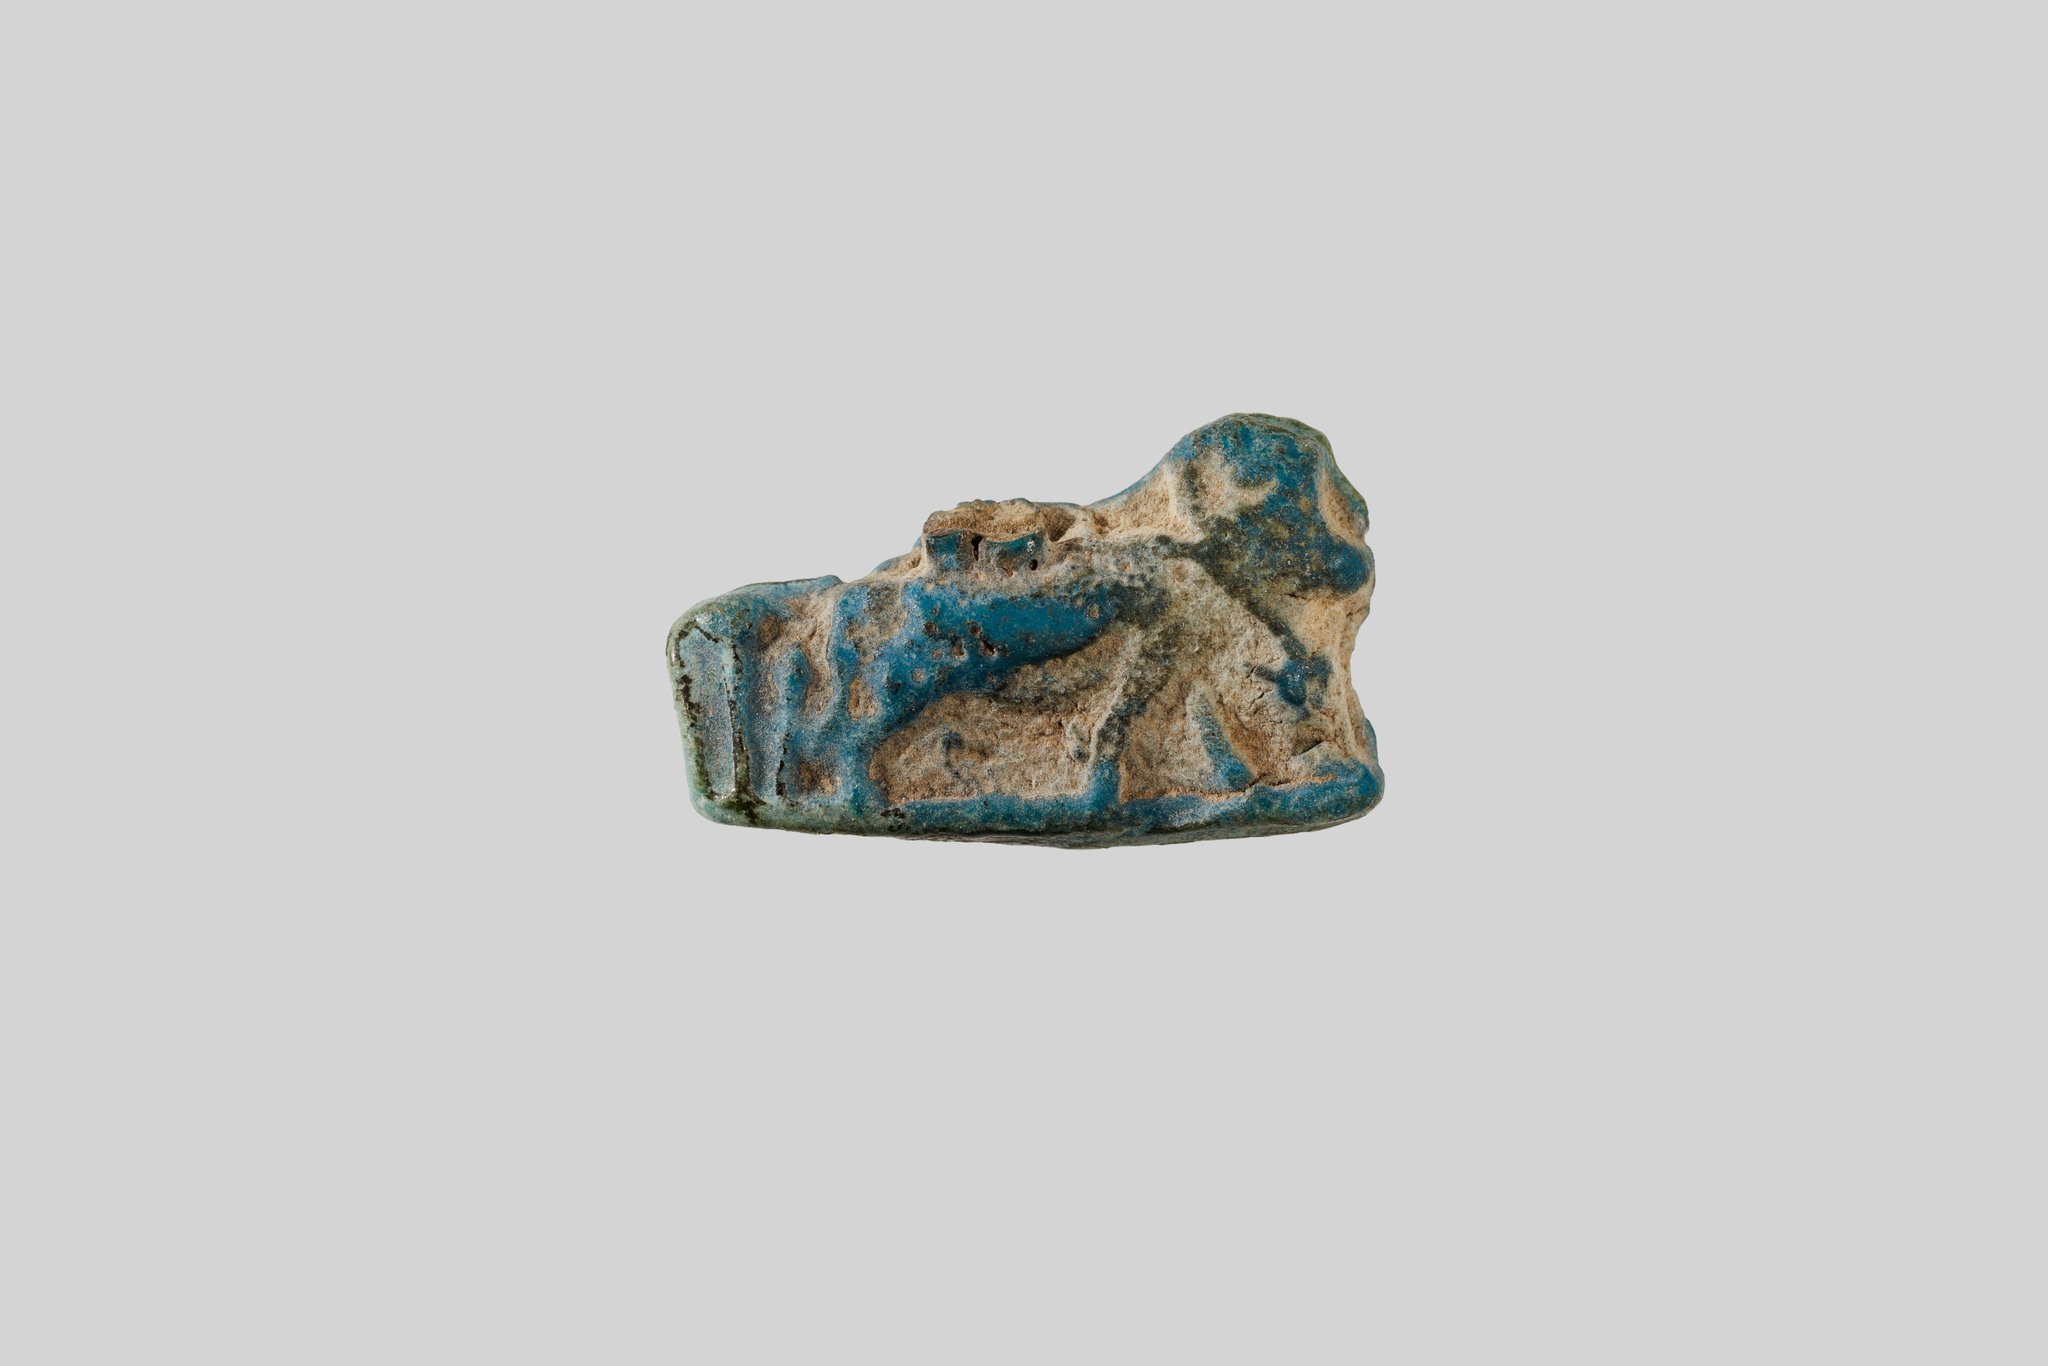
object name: amulet, bull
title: Bull amulet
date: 1295-1070 BCE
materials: faience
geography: egypt